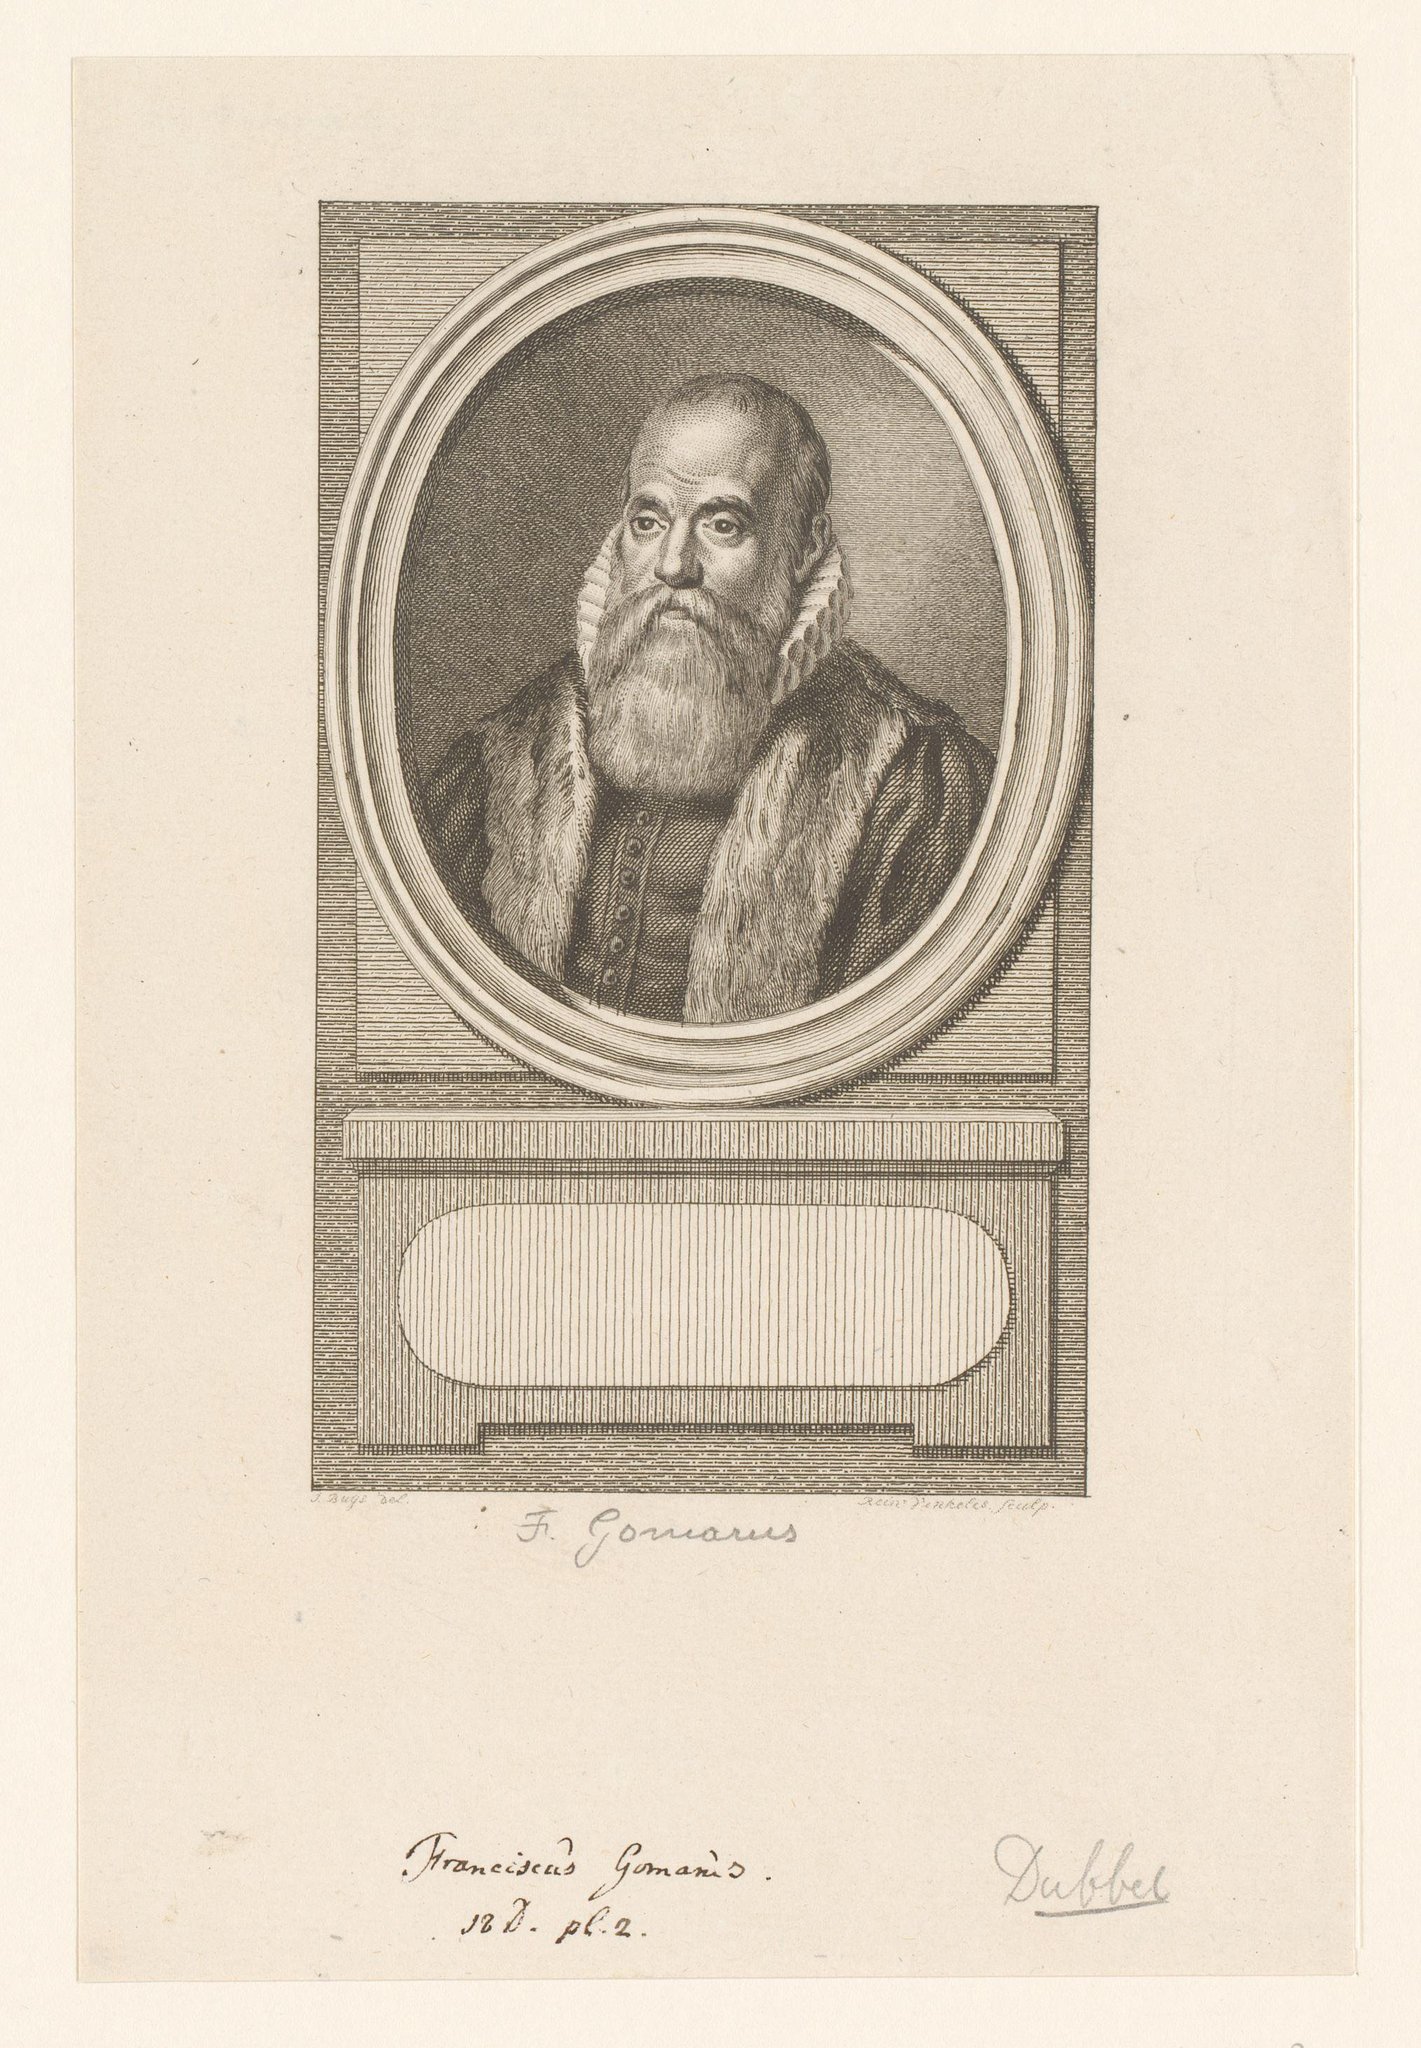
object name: print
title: Portret van de theoloog Franciscus Gomarus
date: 1788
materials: paper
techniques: etching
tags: theologian, historical persons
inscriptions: inscription: ‘Franciscùs Gomarùs./ 12D. pl. 2.’, collector's mark: Lugt 240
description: Latere staat prent gebruikt als boekillustratie in: Kok, Jacobus. Vaderlandsch woordenboek : met kaarten, plaaten en pourtraitten. Amsterdam: Johannes Allart, 1785-1796, deel XI.